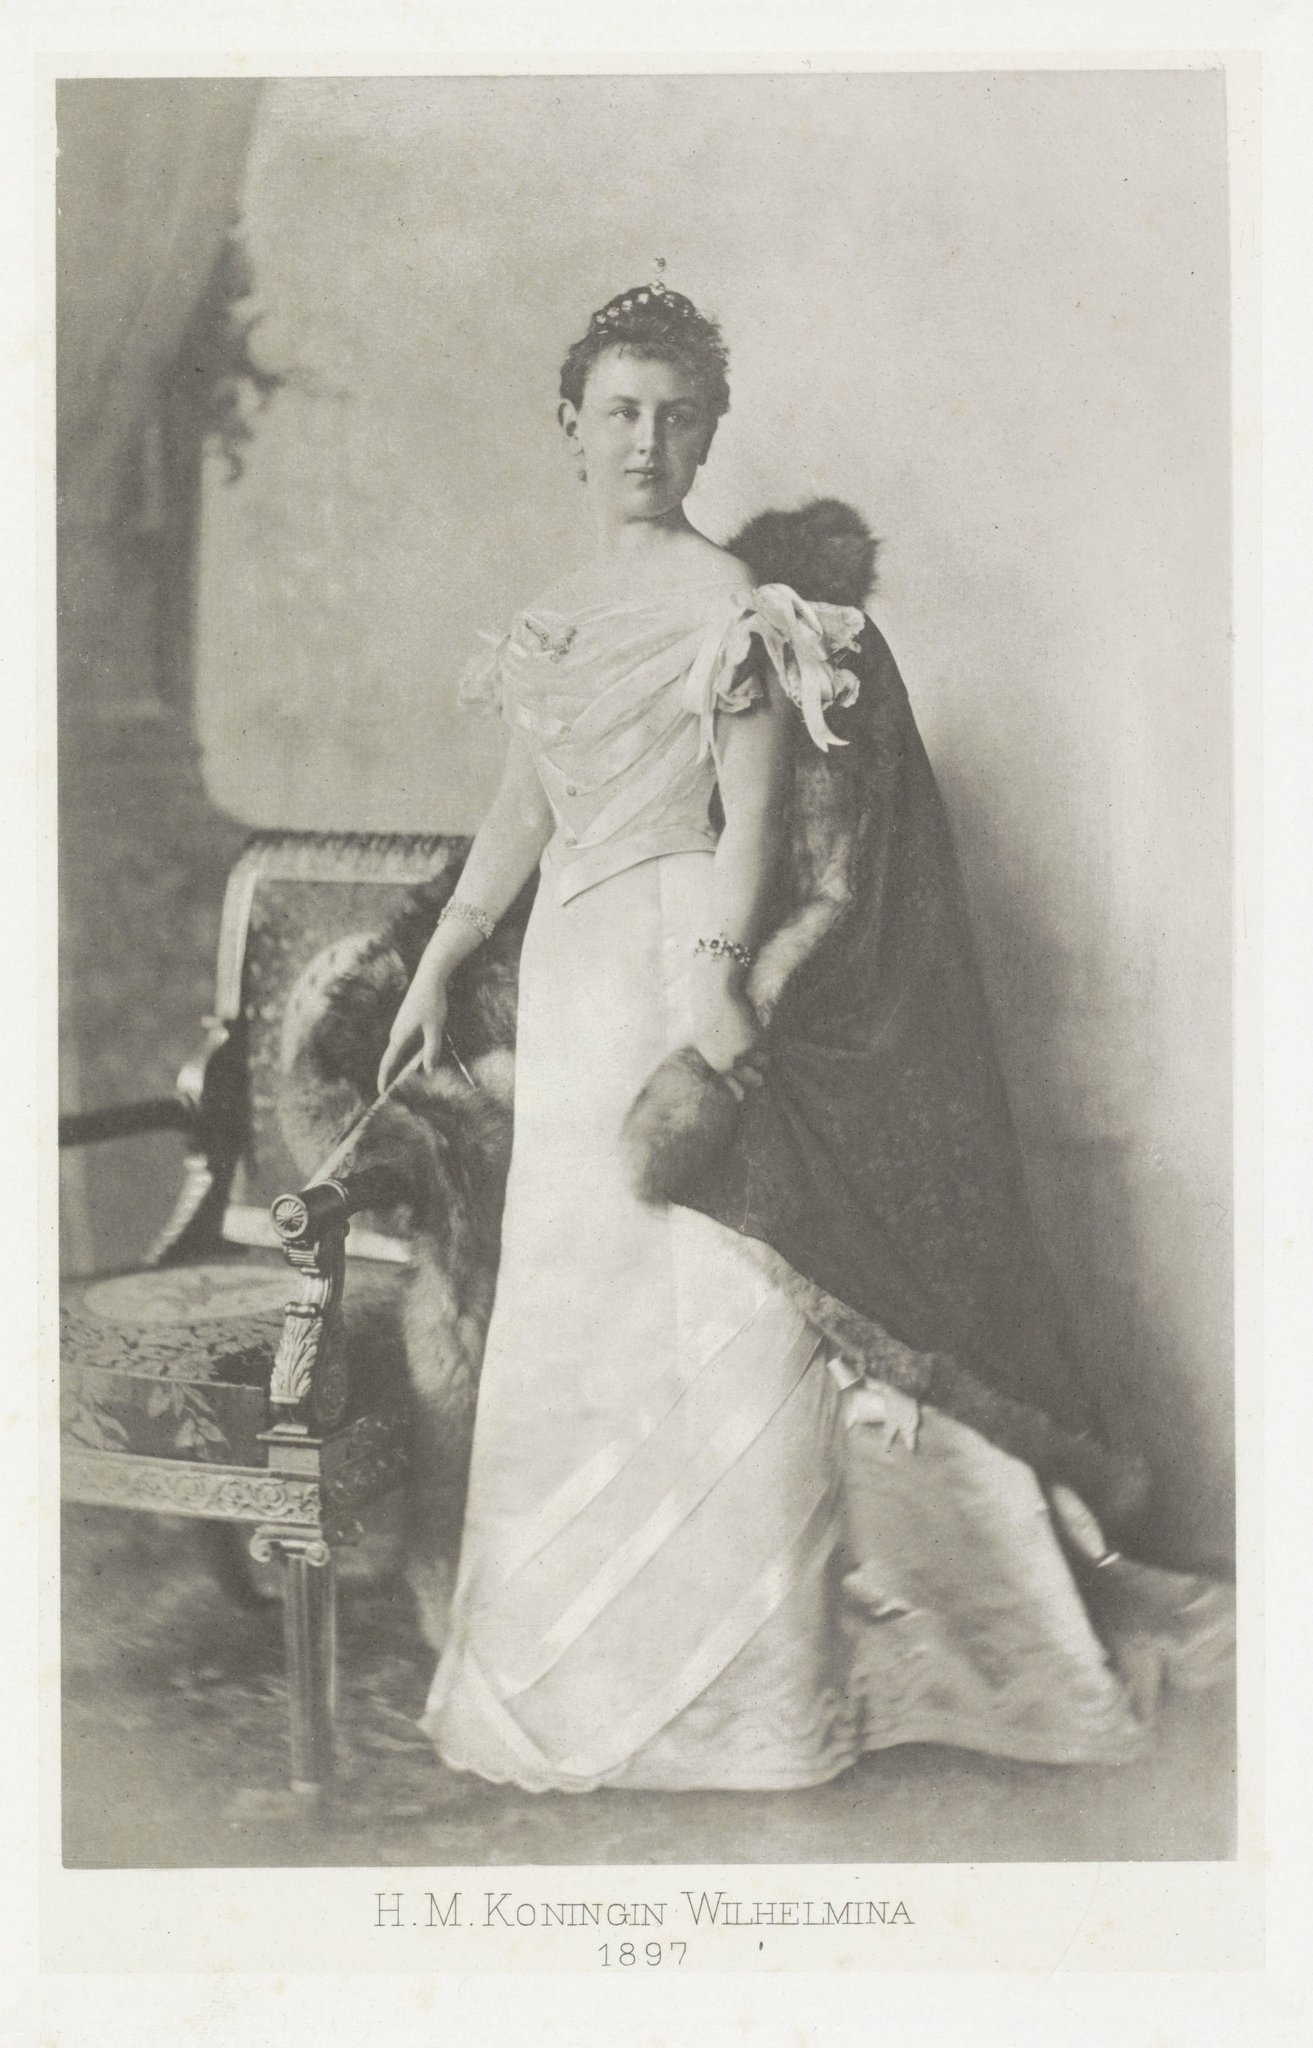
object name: photomechanical print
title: Portret van Wilhelmina, koningin der Nederlanden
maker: heinrich wilhelm wollrabe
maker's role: fotograaf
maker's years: 1843-1928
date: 1897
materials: paper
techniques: photoaquatint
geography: berlin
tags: the hague, wilhelmina of the netherlands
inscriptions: date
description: De hier vermelde titel verwijst naar de hoogst verkregen titel van de geportretteerde, niet per se naar de titel die de geportretteerde op deze voorstelling draagt.